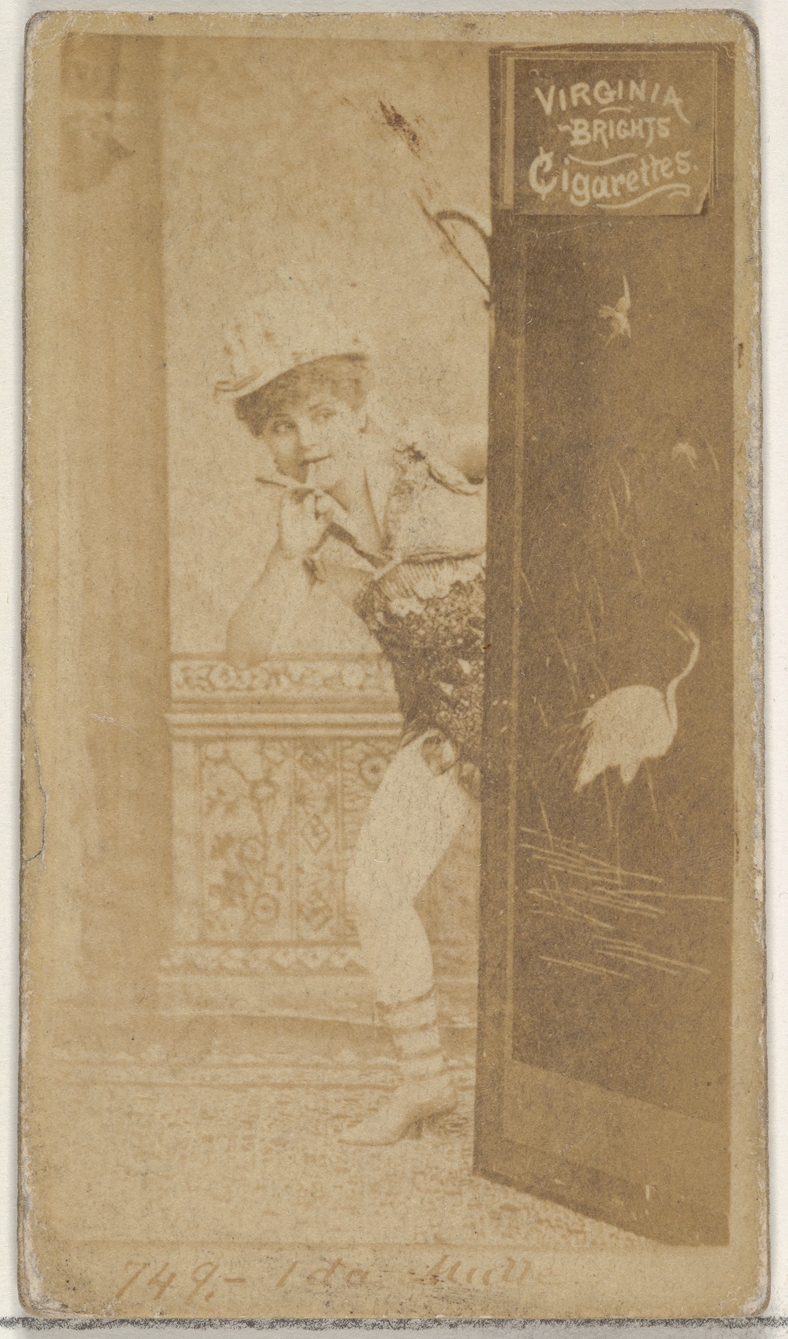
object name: photograph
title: Card 749, Ida Mulle, from the Actors and Actresses series (N45, Type 2) for Virginia Brights Cigarettes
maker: allen & ginter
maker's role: publisher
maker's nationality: american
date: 1888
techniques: albumen silver print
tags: portraits,women,actresses